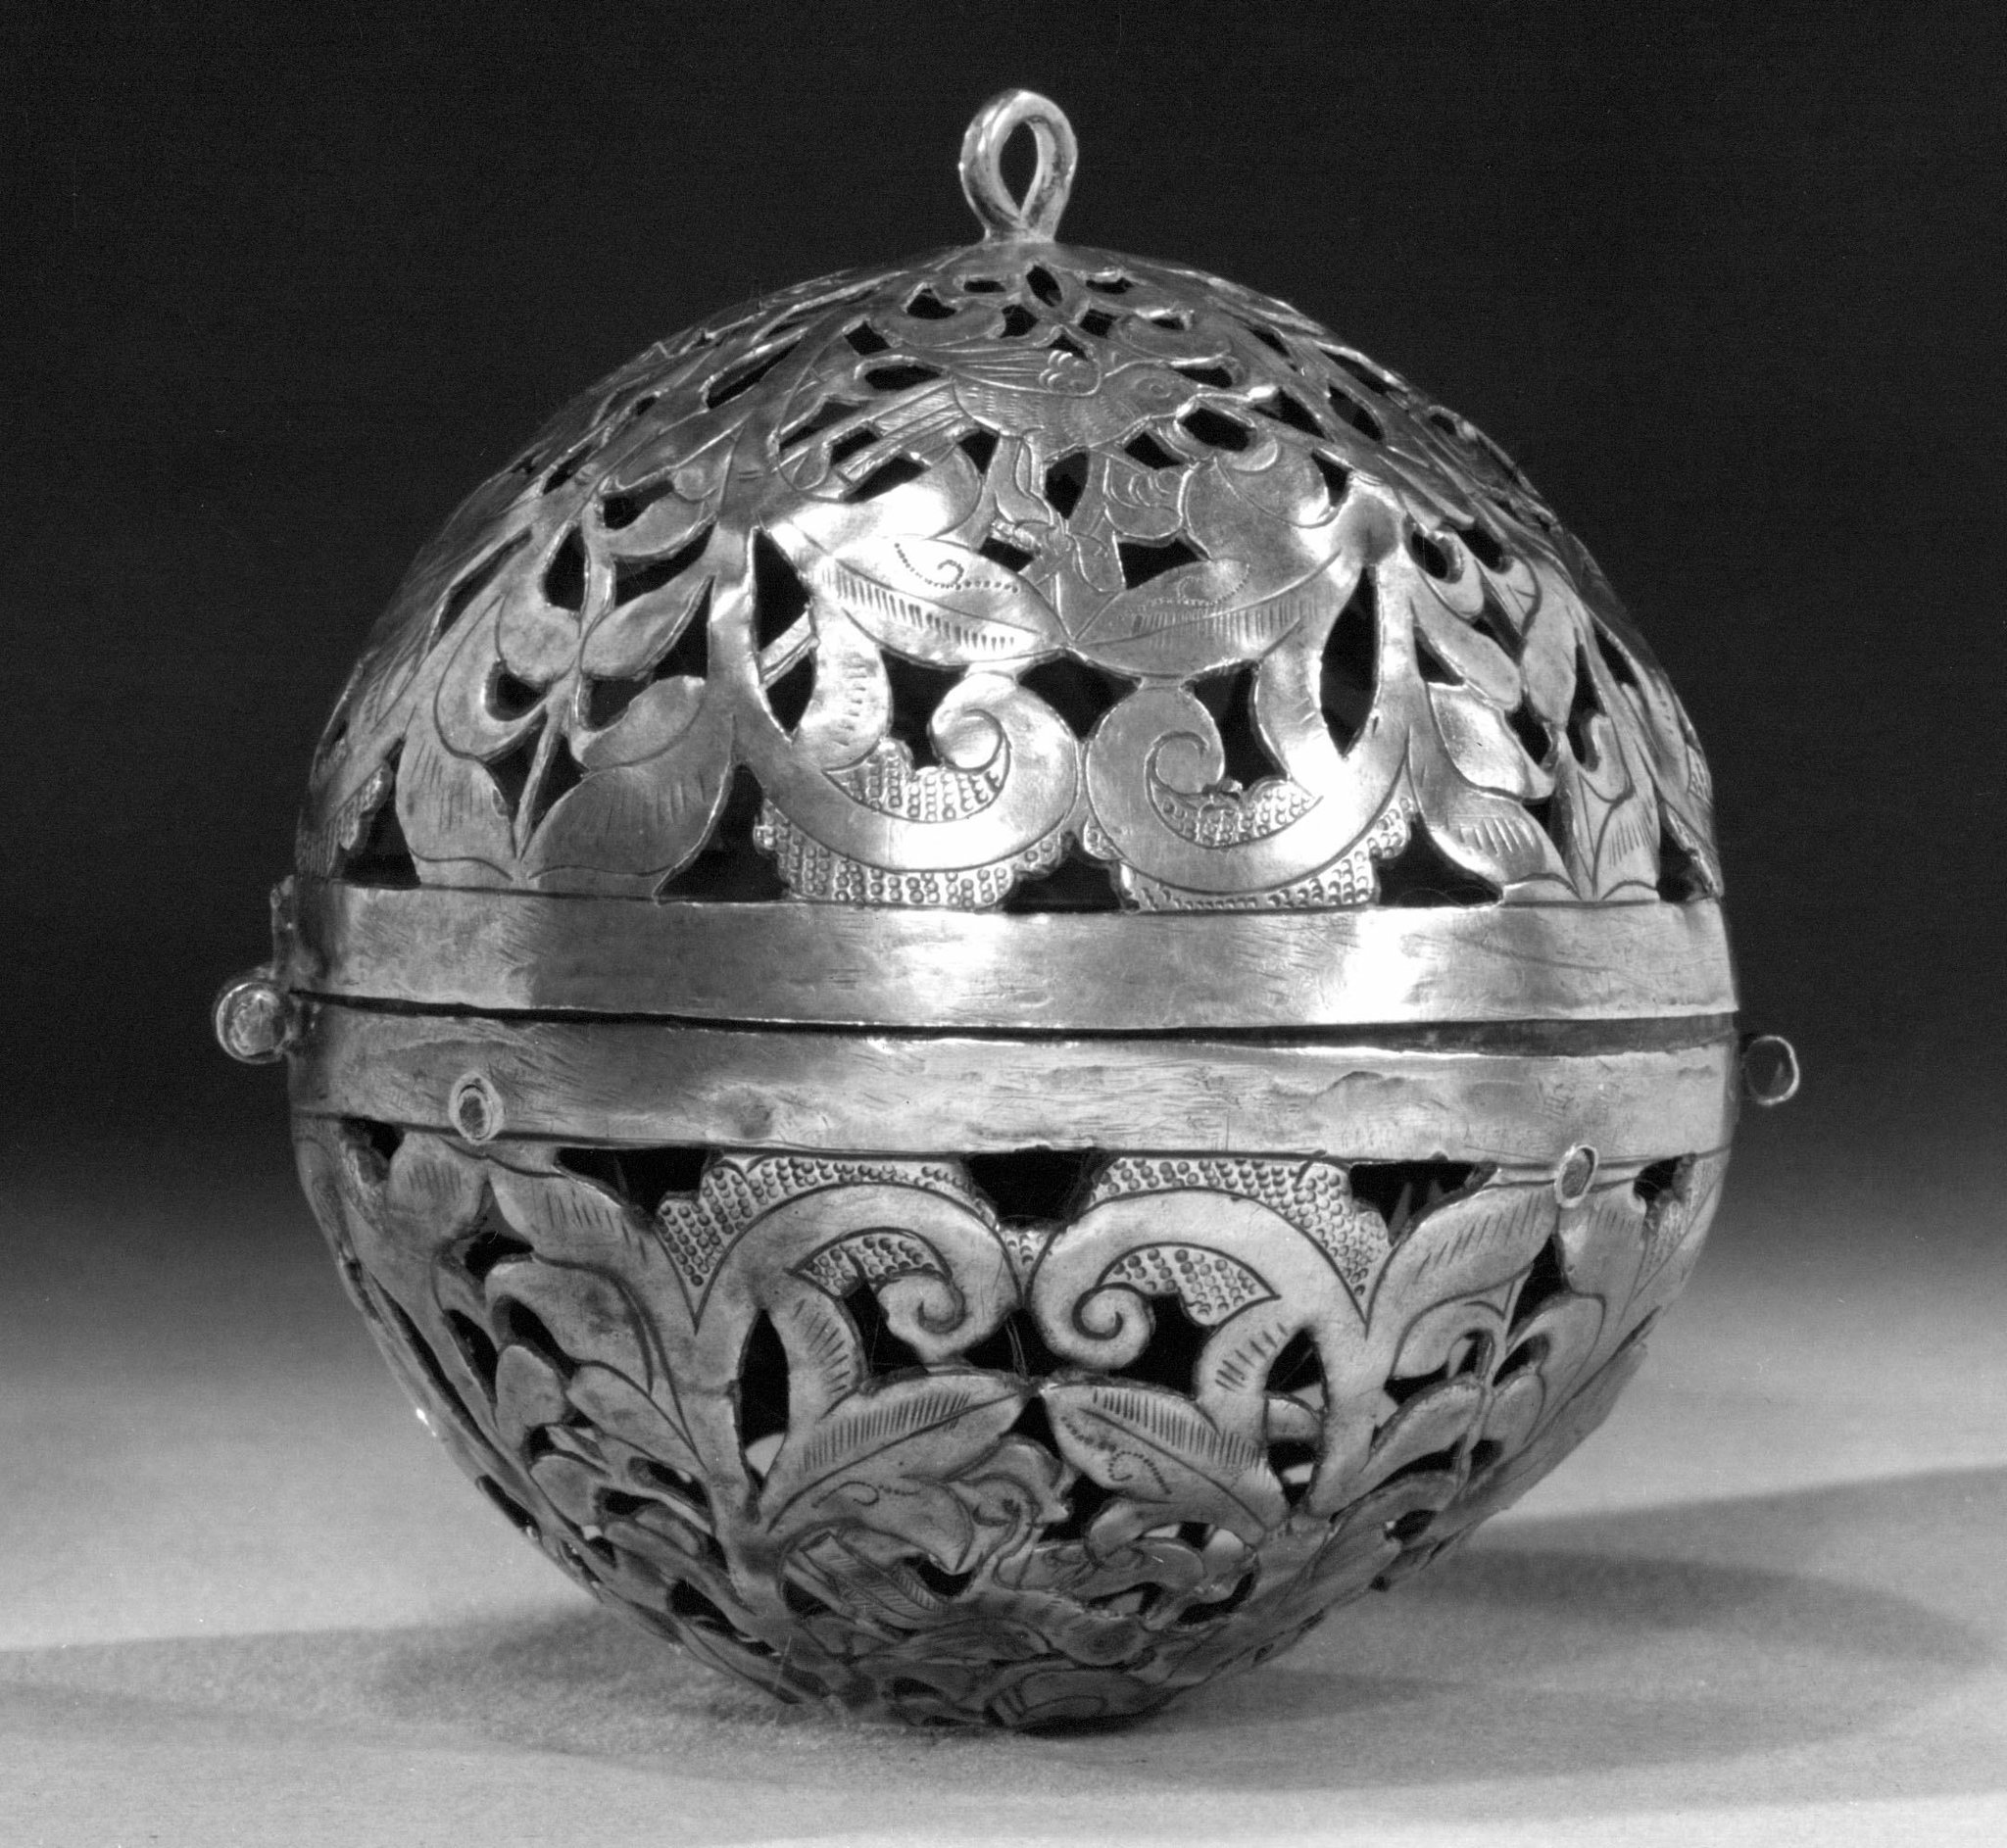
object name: censer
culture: chinese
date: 701-900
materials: silver